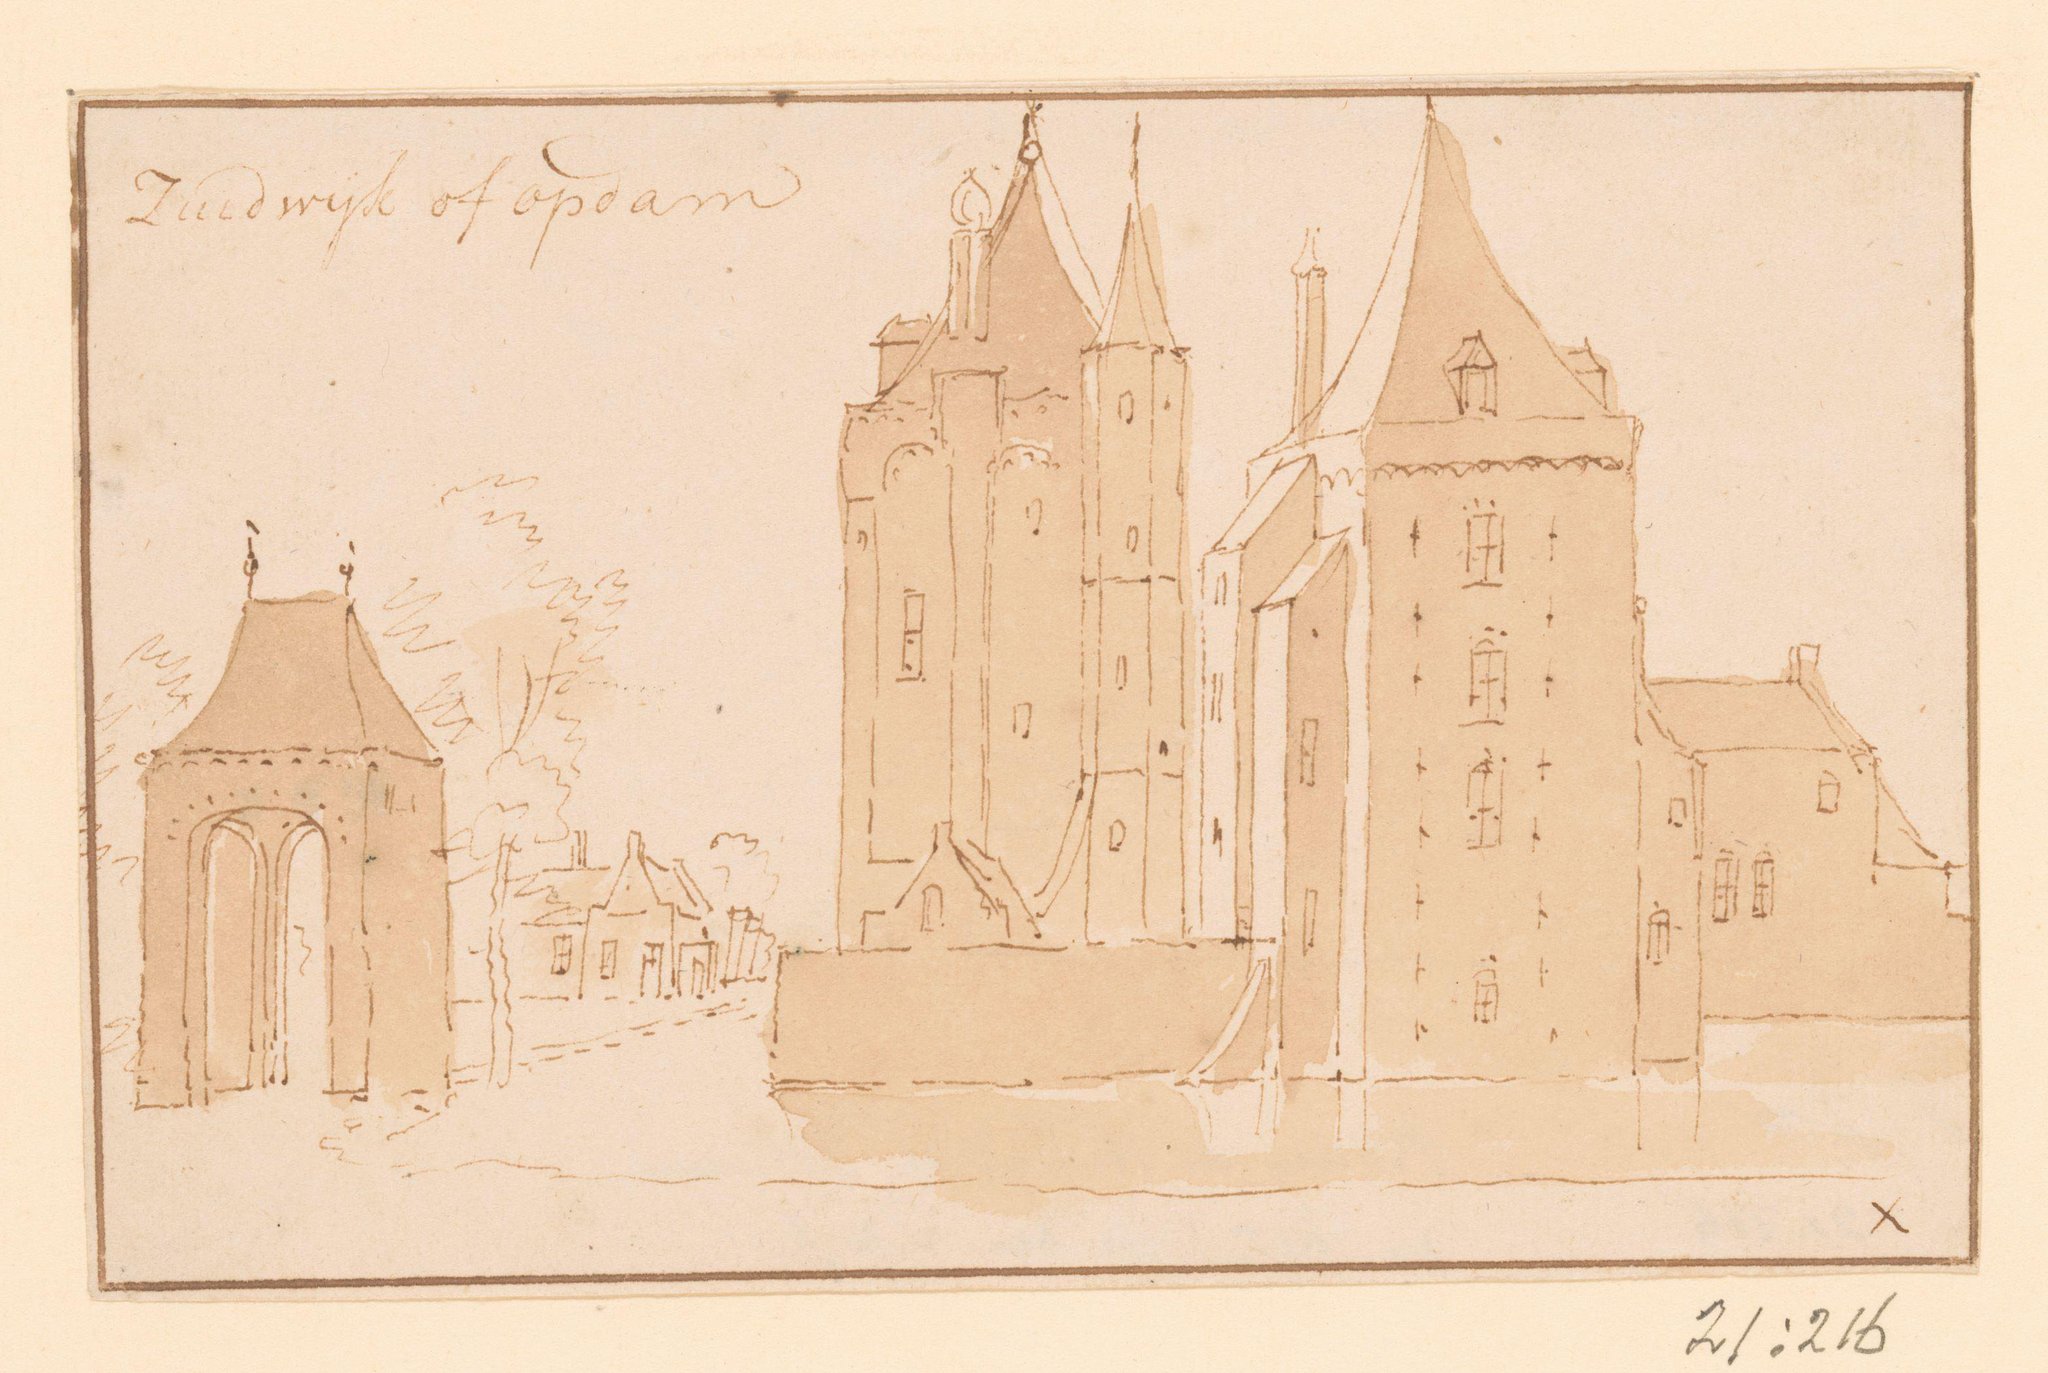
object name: drawing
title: Zuidwijk of opdam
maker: Anonymous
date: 1700-1800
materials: ink, paper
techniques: brush, pen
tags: castle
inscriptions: collector's mark: Lugt 2233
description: Op verso een schets van een kasteelgebouw.